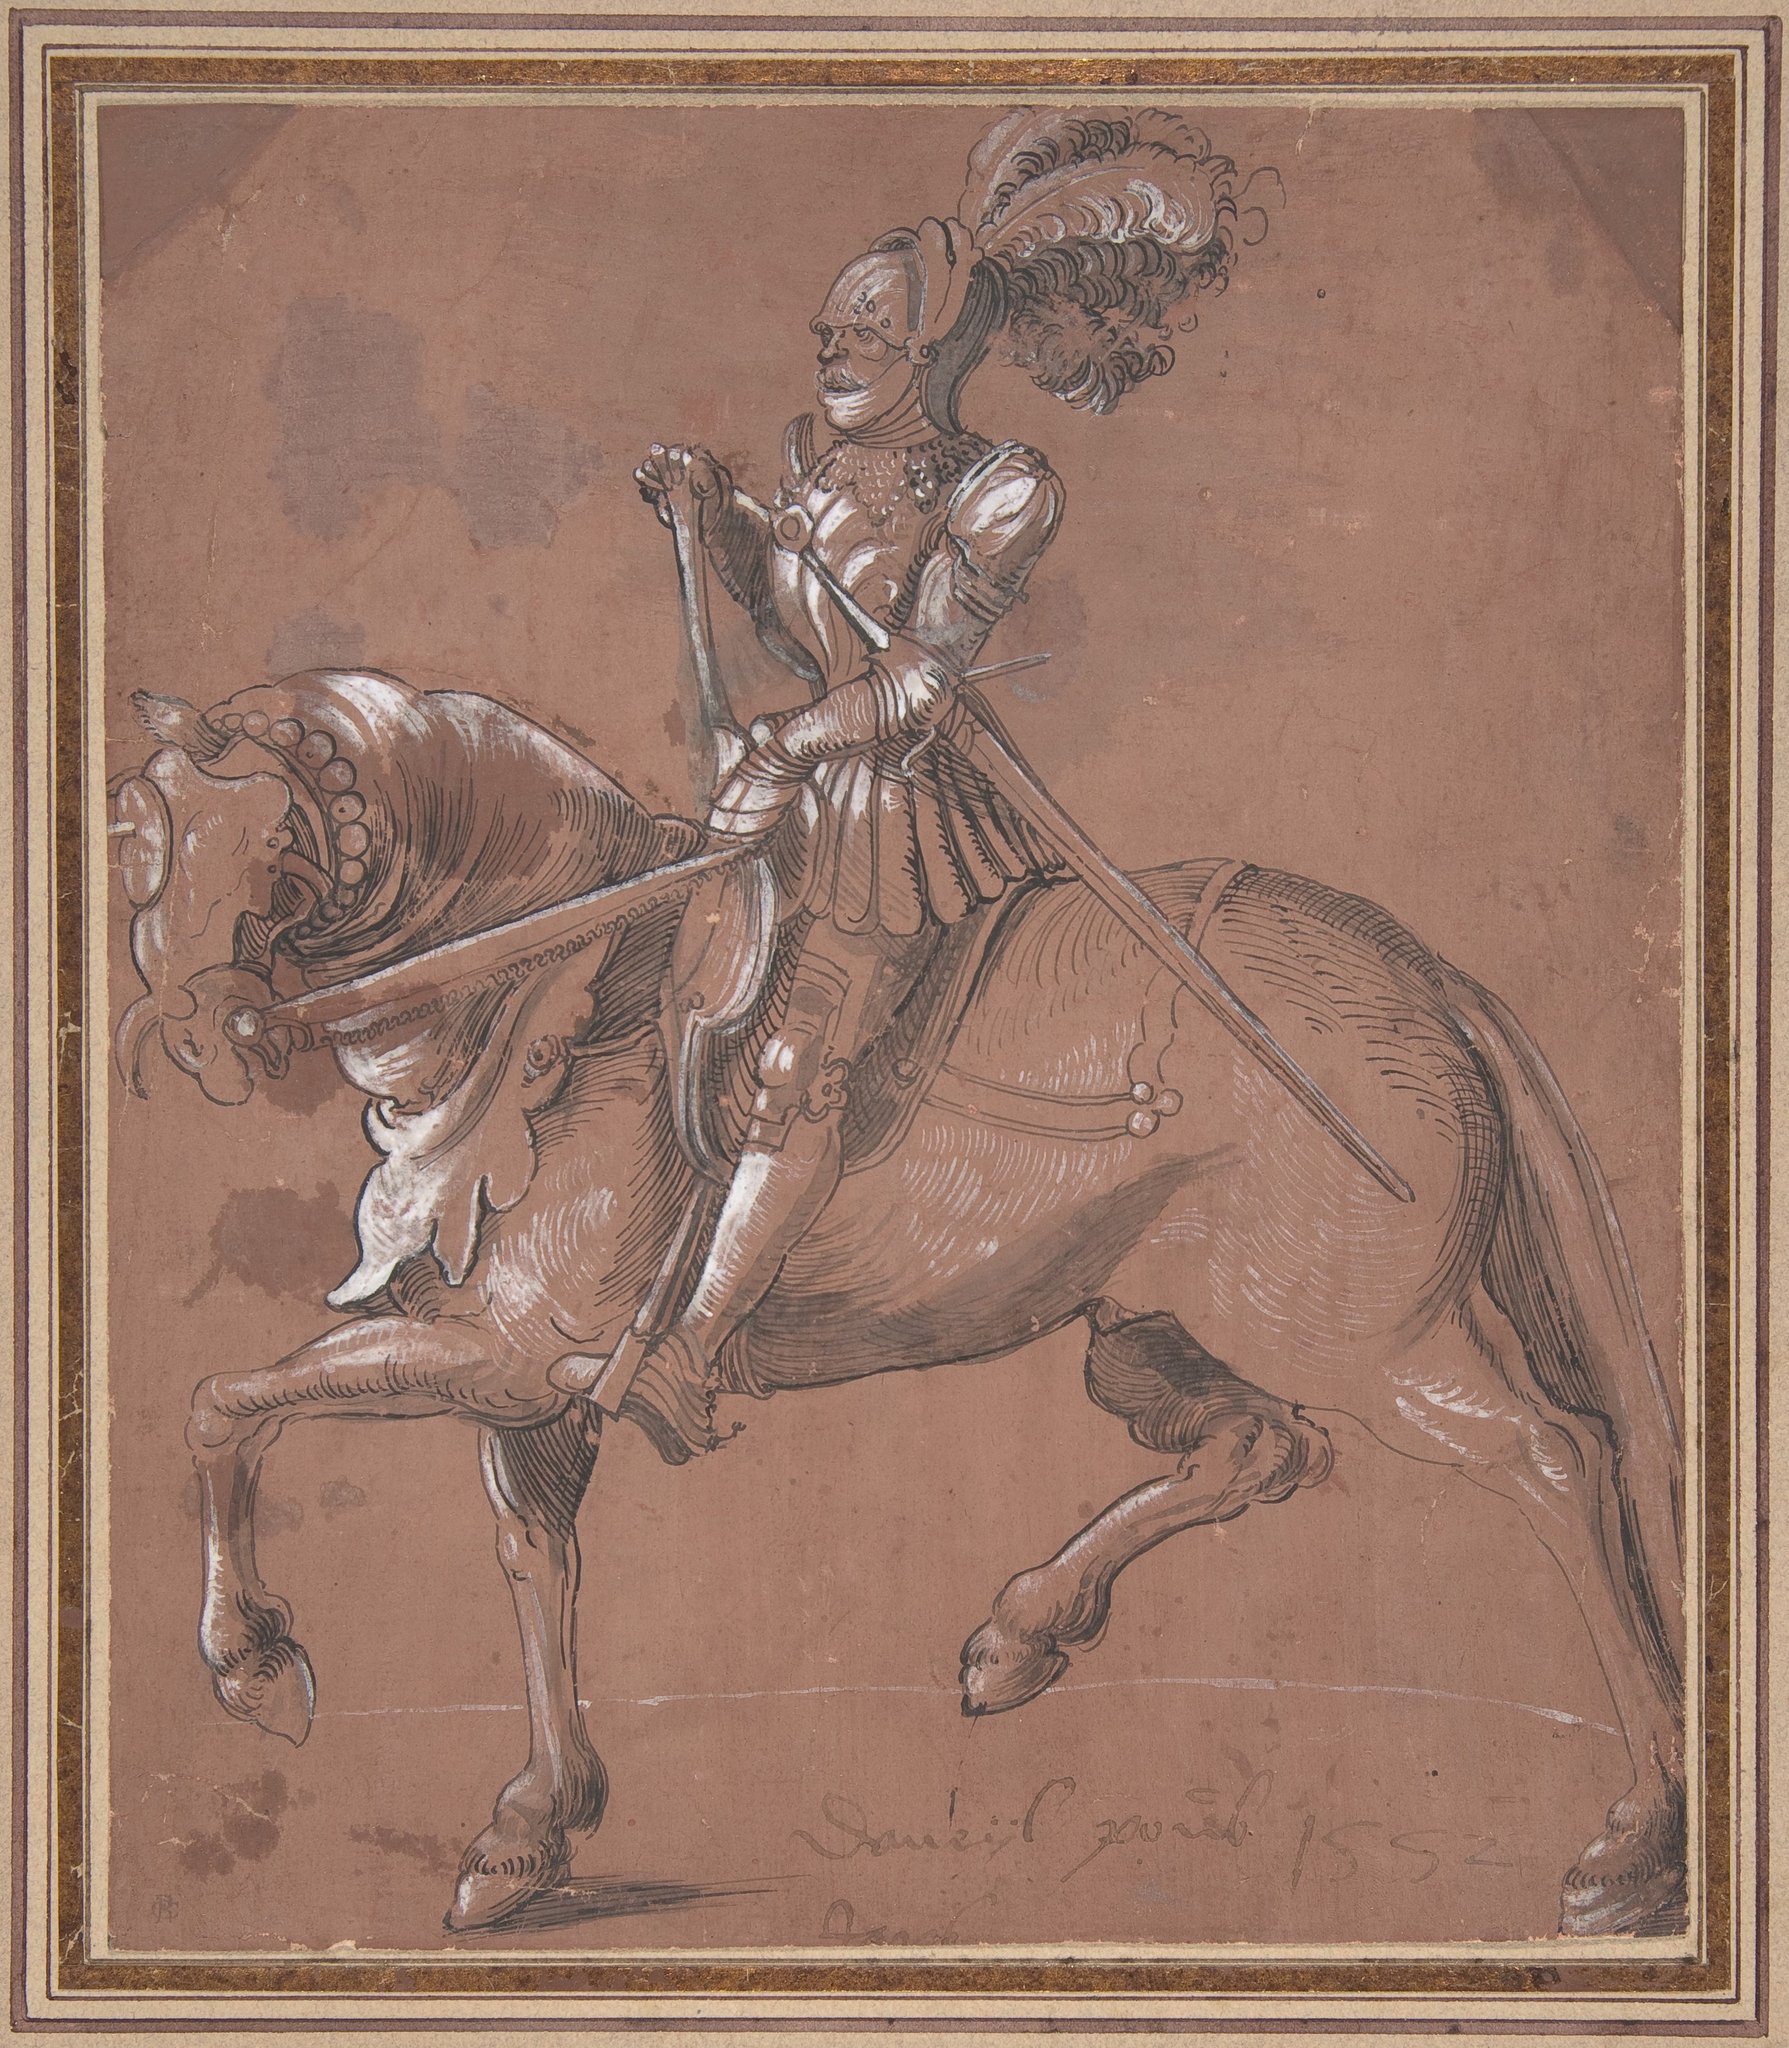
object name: drawing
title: Knight on Horseback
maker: anonymous, german, 16th century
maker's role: artist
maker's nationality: german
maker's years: 1500-1600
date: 1520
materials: ink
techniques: brush, heightening, pen, wash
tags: swords,horses,knights